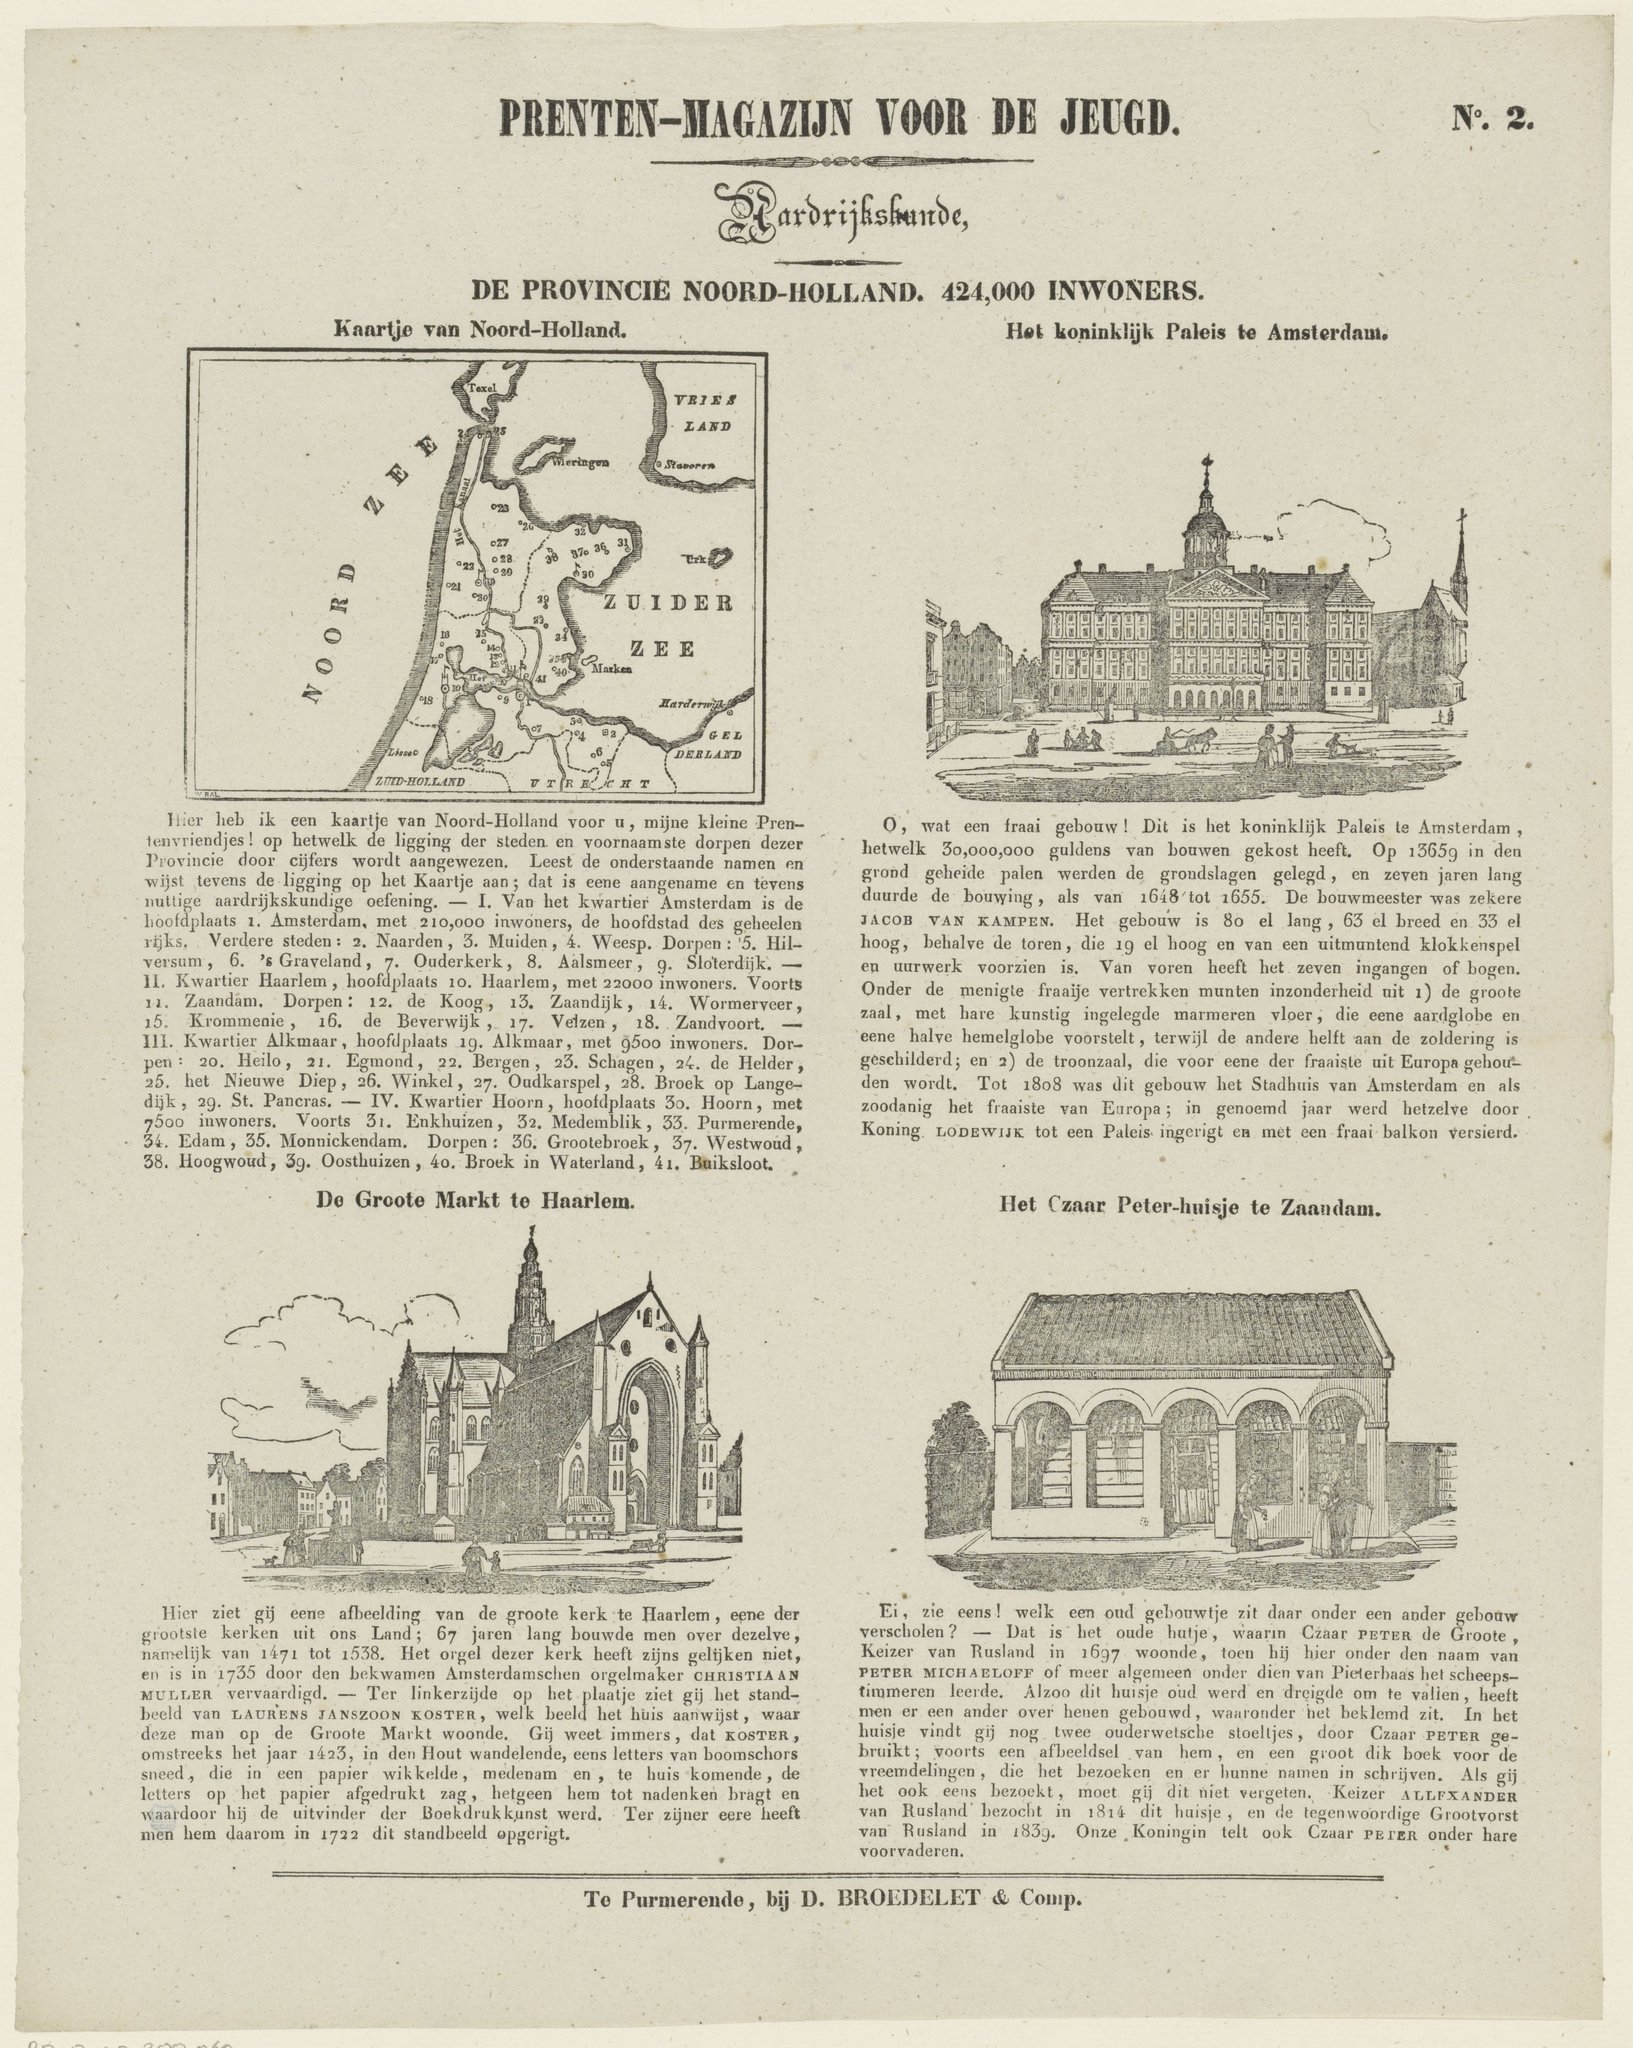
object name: print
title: Aardrijkskunde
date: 1839-1841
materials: paper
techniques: letterpress printing, engraving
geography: netherlands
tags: maps, atlases, palace, roman catholic church, royal palace of amsterdam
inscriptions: collector's mark: Lugt 2760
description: Blad met 4 voorstellingen over de provincie Noord-Holland met een kaart en belangrijke gebouwen: het Paleis op de Dam te Amsterdam, de Grote Markt in Haarlem en het Czaar Peterhuisje te Zaandam. Boven elke voorstelling een titel en onder elke voorstelling twaalf tot achttien regels tekst. Genummerd rechtsboven: No. 2.